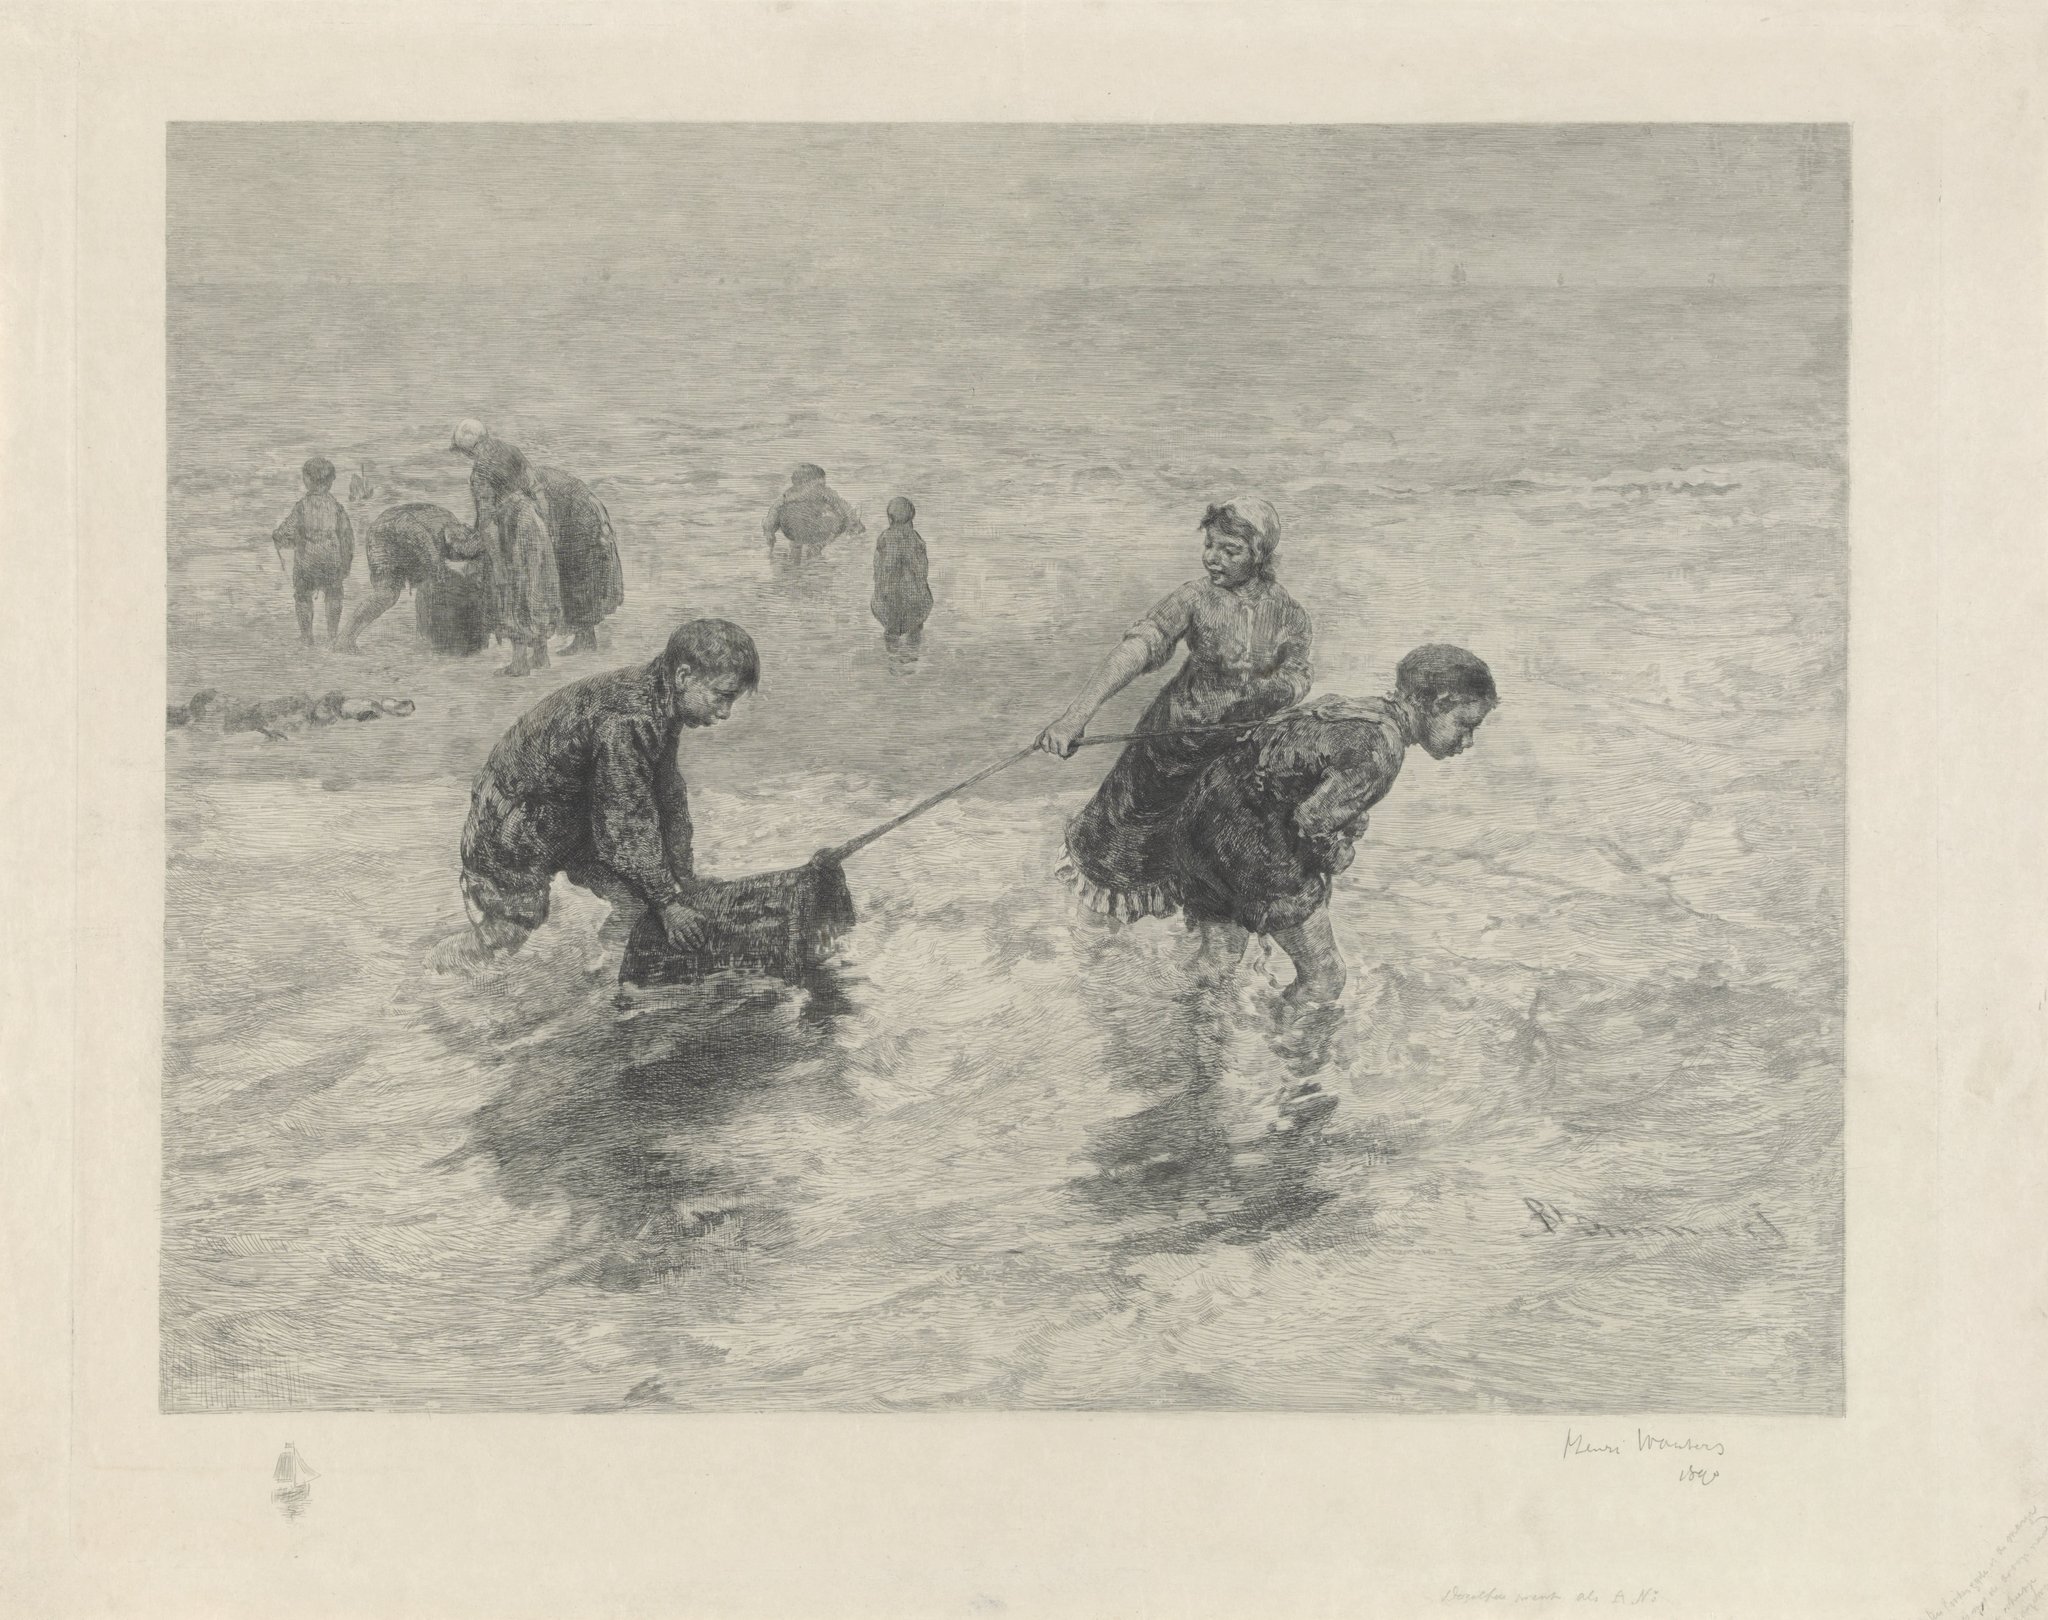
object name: print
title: Kinderen langs de zee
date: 1890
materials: paper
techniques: drypoint, etching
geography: amsterdam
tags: container made of plant material other than wood: basket, sea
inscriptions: collector's mark: Lugt 2228, signature and date: ‘Henri Wouters 1890’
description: Een jongen trekt met een touw op zijn rug een mand door het water. De mand fungeert als een soort zeef om garnaaltjes te vangen. Hij wordt geholpen door een meisje dat aan het touw trekt, en een jongen die de mand duwt. In de marge een klein bootje.